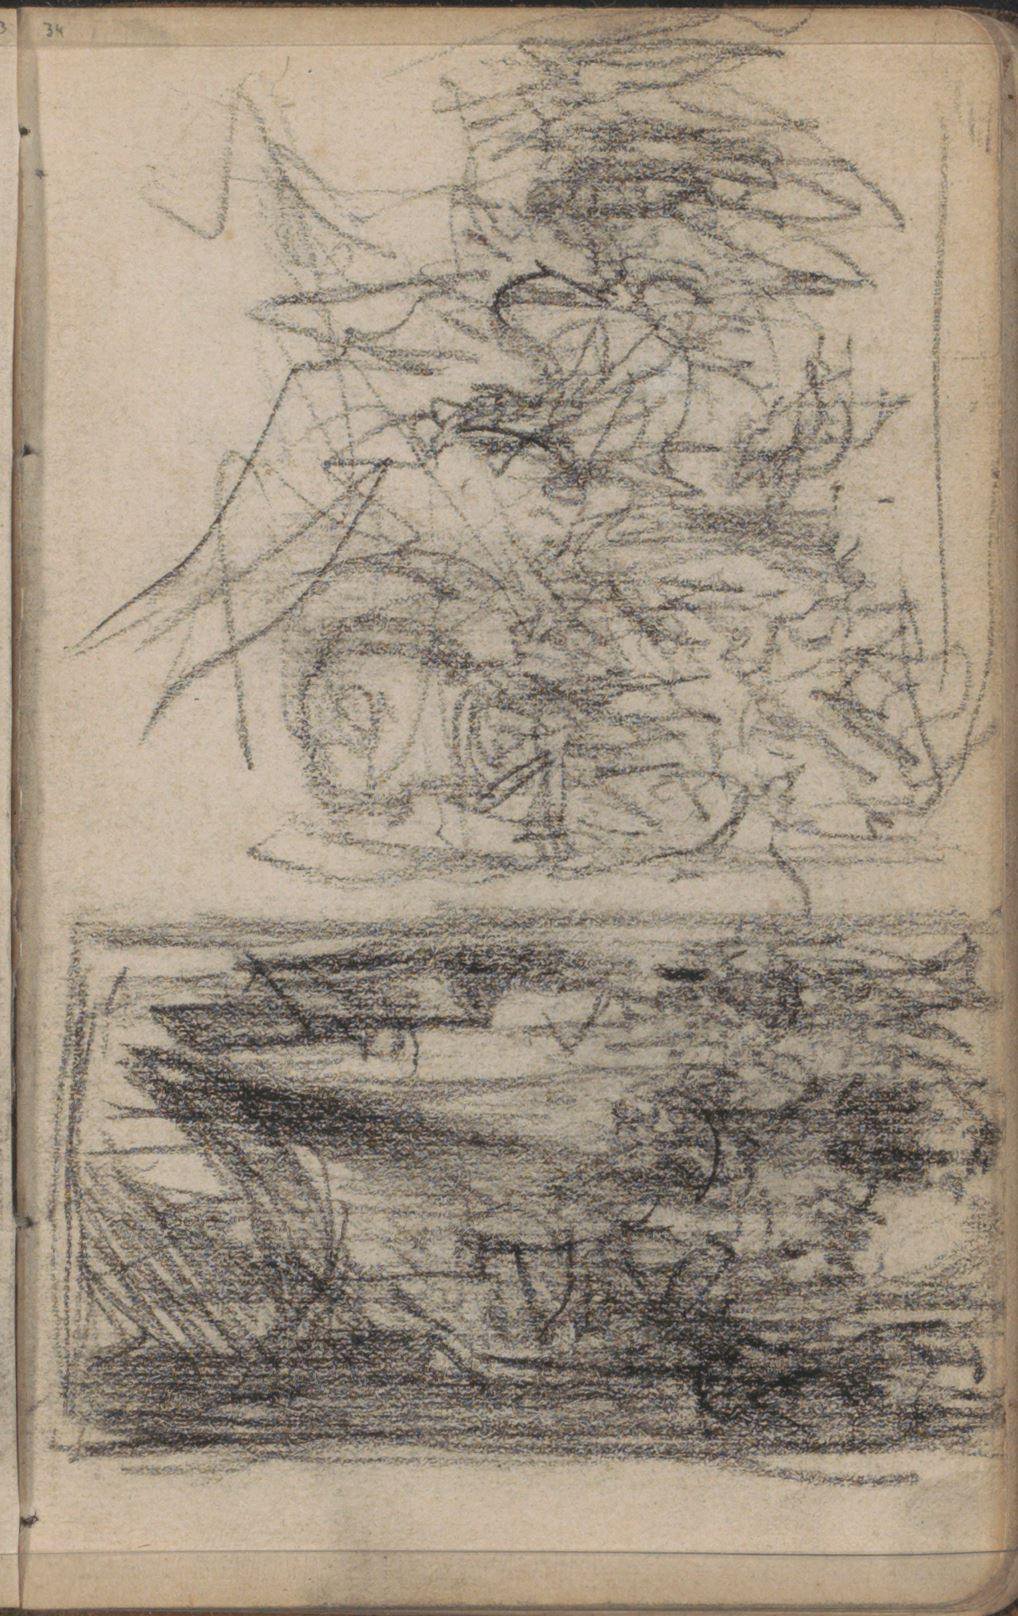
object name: sketchbook leaf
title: Studies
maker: marius bauer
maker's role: draughtsman, print maker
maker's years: 1867-1932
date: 1879-1885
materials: chalk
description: Pagina 34 uit een schetsboek met 58 bladen.